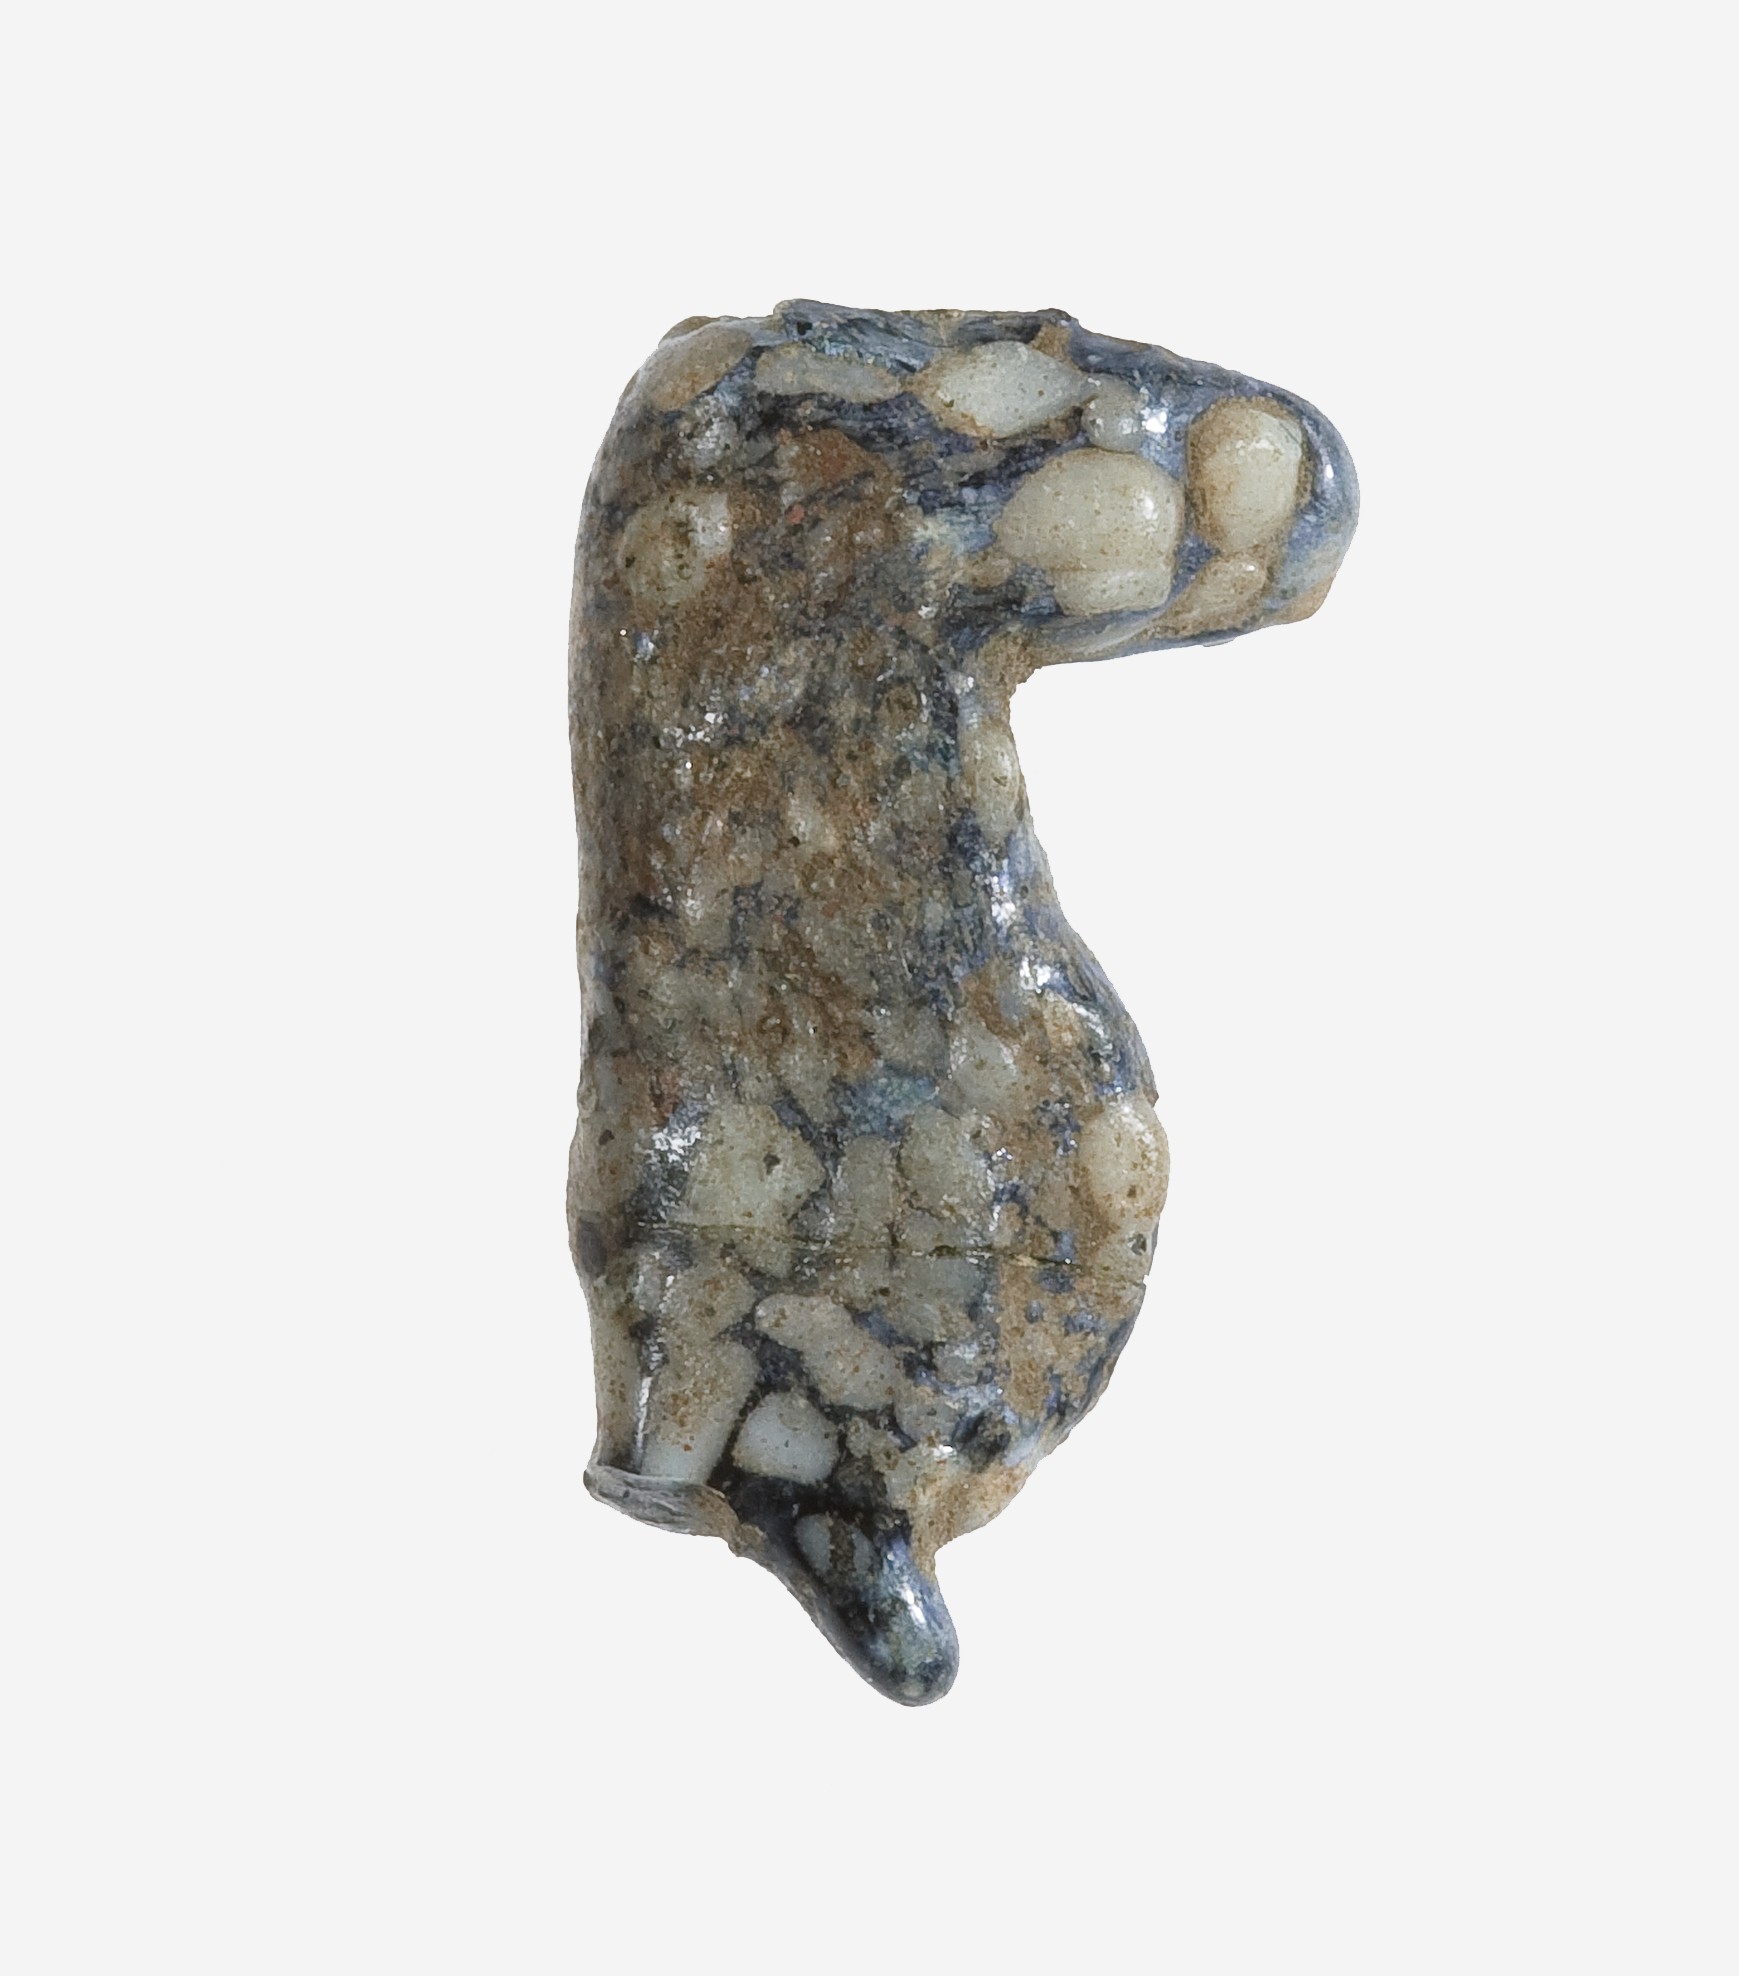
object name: amulet, taweret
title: Amulet: Taweret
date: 1390-1352 BCE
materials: glass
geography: egypt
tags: taweret